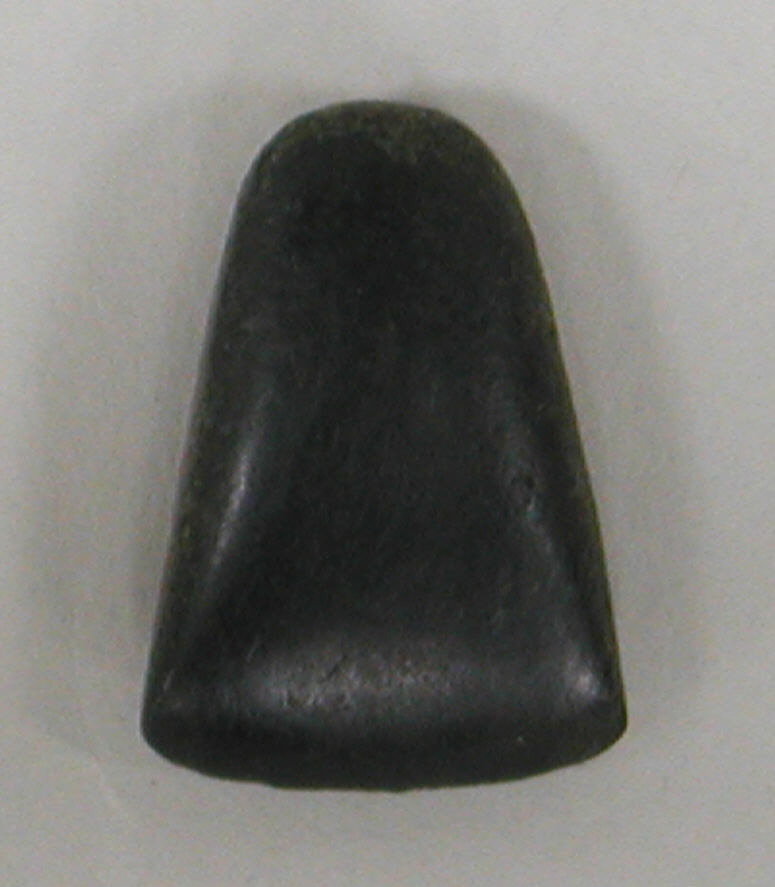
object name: chisel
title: Stone Chisel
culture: maya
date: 1501-1600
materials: stone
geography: guatemala